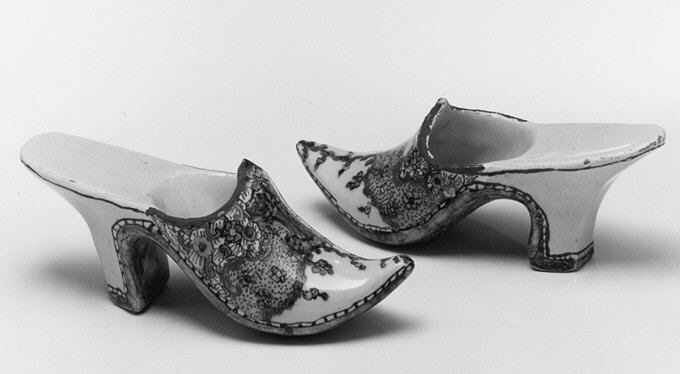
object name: shoe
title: Pair of miniature shoes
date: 1701-1733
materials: earthenware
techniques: glazing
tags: shoes